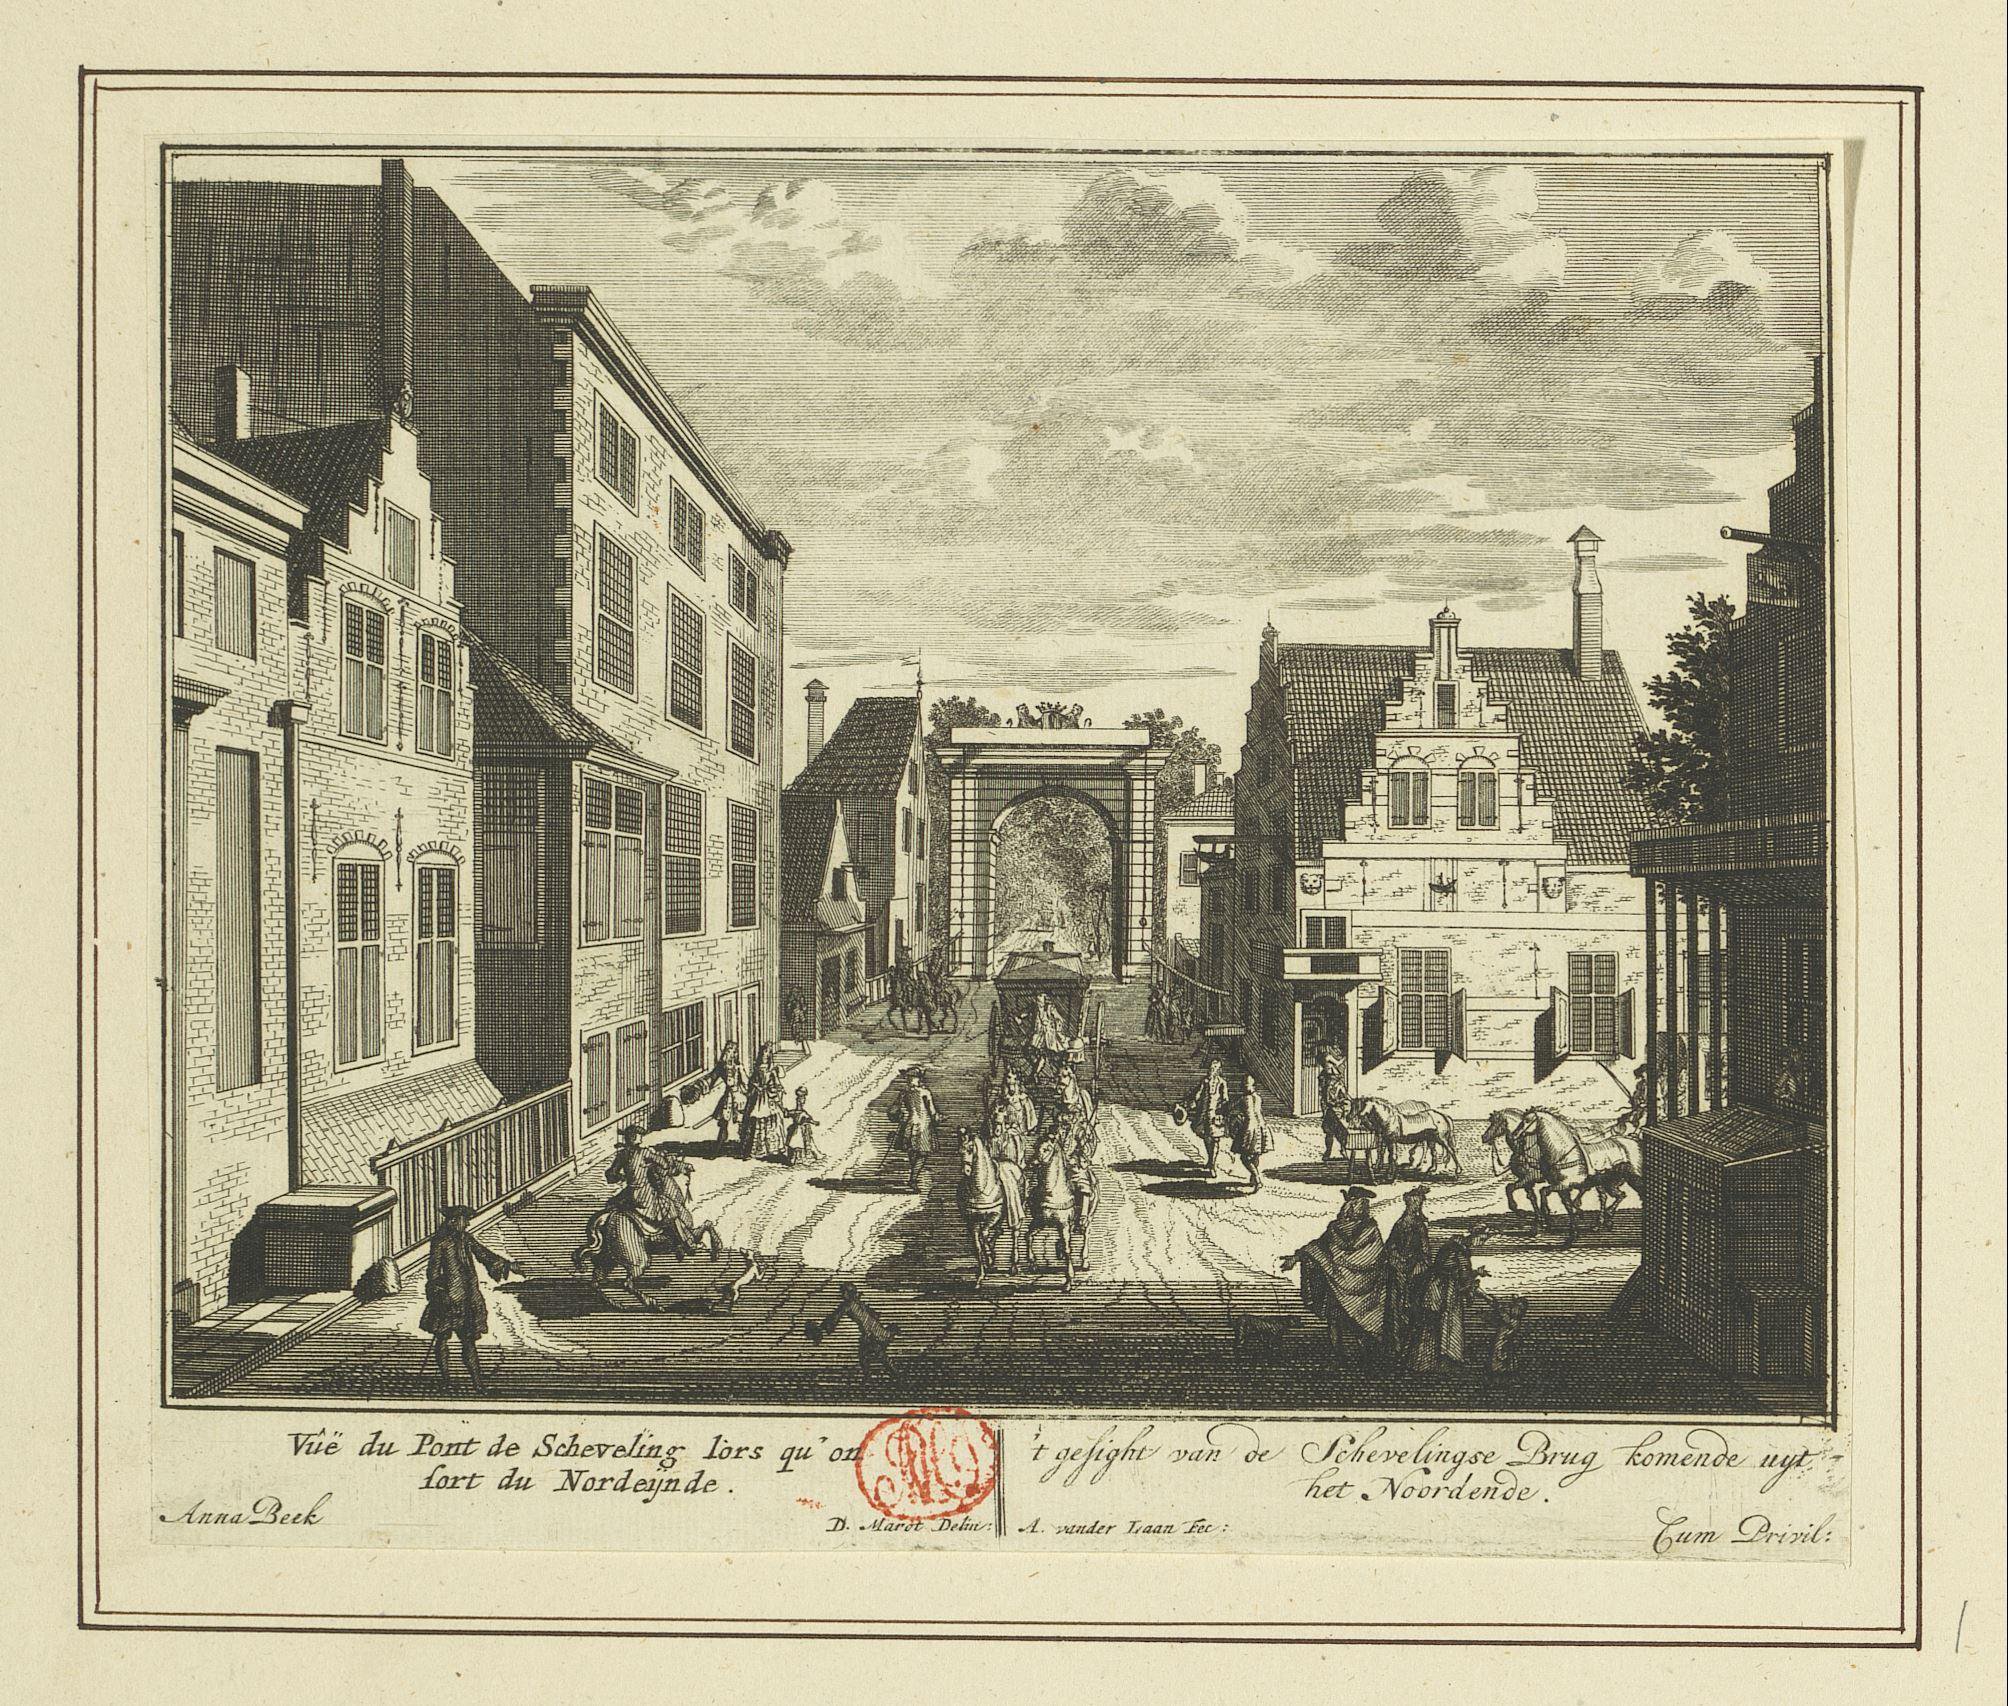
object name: print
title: 't Gesight van de Schevelingse Brug komende uyt het Noordende / Vûë du Pont de Scheveling lors qu'on sort du Nordeijnde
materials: paper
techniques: engraving, etching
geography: the hague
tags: bridge, street (+ city(-scape) with figures, staffage)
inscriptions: collector's mark: Lugt 195, collector's mark: Lugt 2228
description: Mogelijk uitgegeven als onderdeel van een serie van veertien gezichten in Den Haag. Zie ook RP-P-AO-12-118-1, RP-P-AO-12-118-2, RP-P-AO-12-118-3, RP-P-AO-12-118-4, RP-P-AO-12-118-5, RP-P-AO-12-118-6, RP-P-AO-12-118-7, RP-P-AO-12-118-8, RP-P-AO-12-118-9, RP-P-AO-12-118-10, RP-P-AO-12-118-11, RP-P-AO-12-118-12, RP-P-AO-12-118-13, RP-P-2016-2145, RP-P-2016-2146, RP-P-2016-2147, RP-P-2016-2148, RP-P-2016-2149, RP-P-2016-2150 en RP-P-2016-2151.